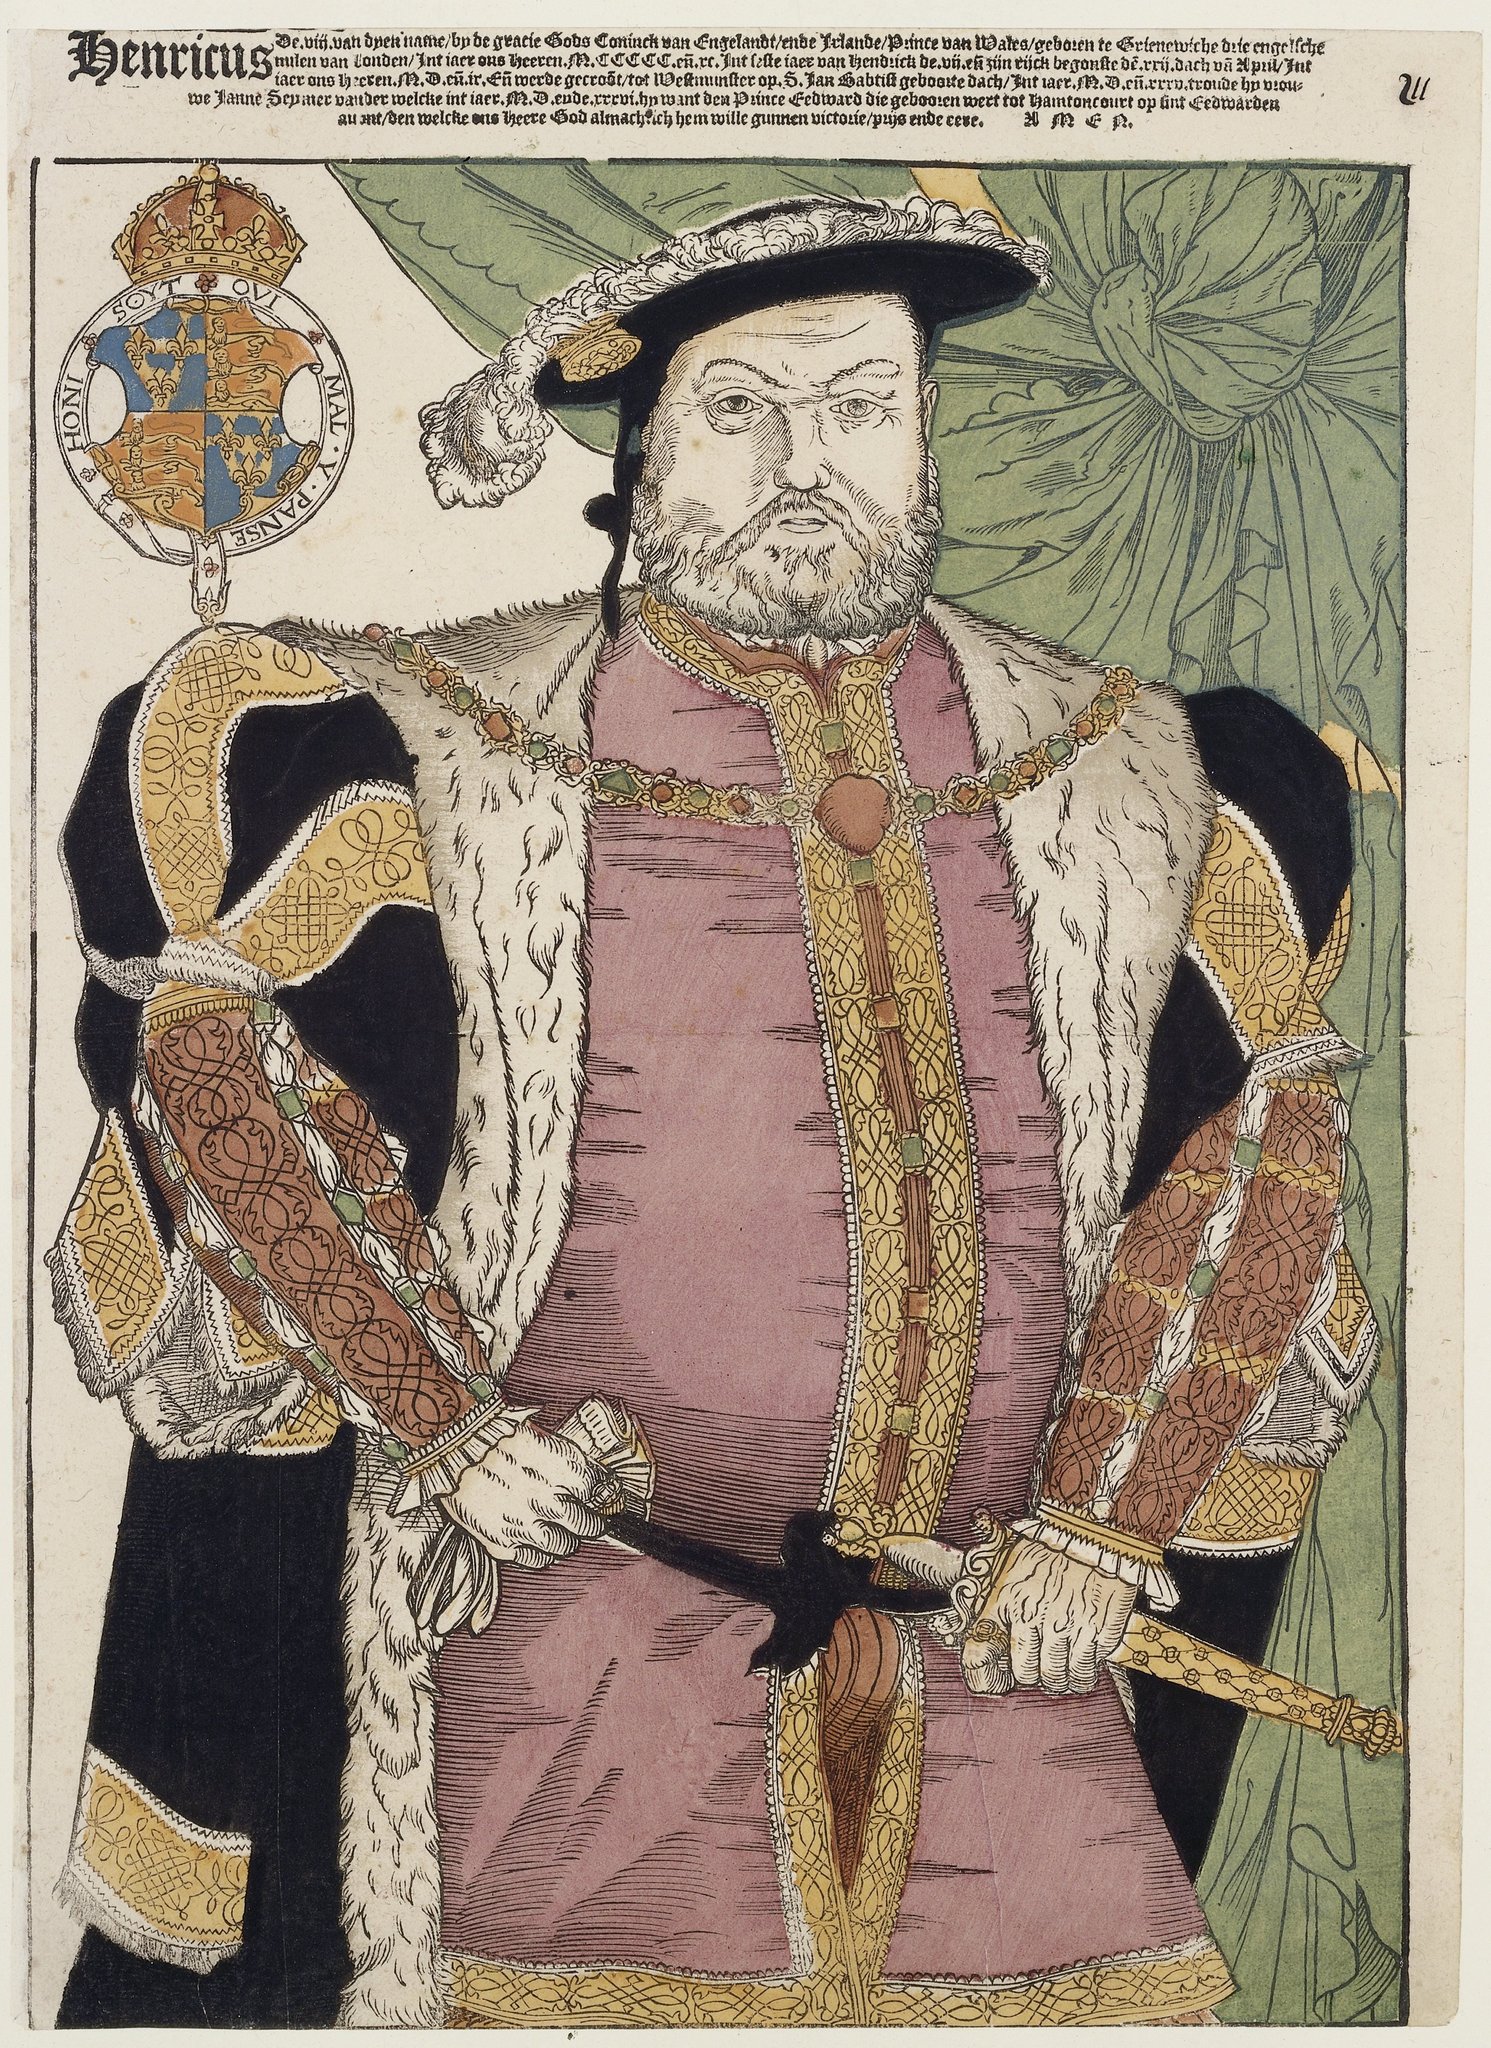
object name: print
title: Portret van Hendrik VIII van Engeland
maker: Anonymous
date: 1547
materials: paper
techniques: hand coloring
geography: low countries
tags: historical persons, king, armorial bearing, heraldry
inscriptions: number: ‘211’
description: Hendrik de VIII van Engeland (1491-1547), gekleed in lila rok en zwarte mantel met goudgeel passement, zandkleurige bontvoering, roodbruine ondermouwen. Zwarte baret en gordel. Kniestuk, frontaal tegen een opgenomen gordijn, gevat in een randlijn, waarbinnen het gekroonde Engelse wapen met de Orde van de Kousenband. Boven de randlijn vijfregelig opschrift in het Nederlands. Pendant van Portret Edward VI van Engeland.